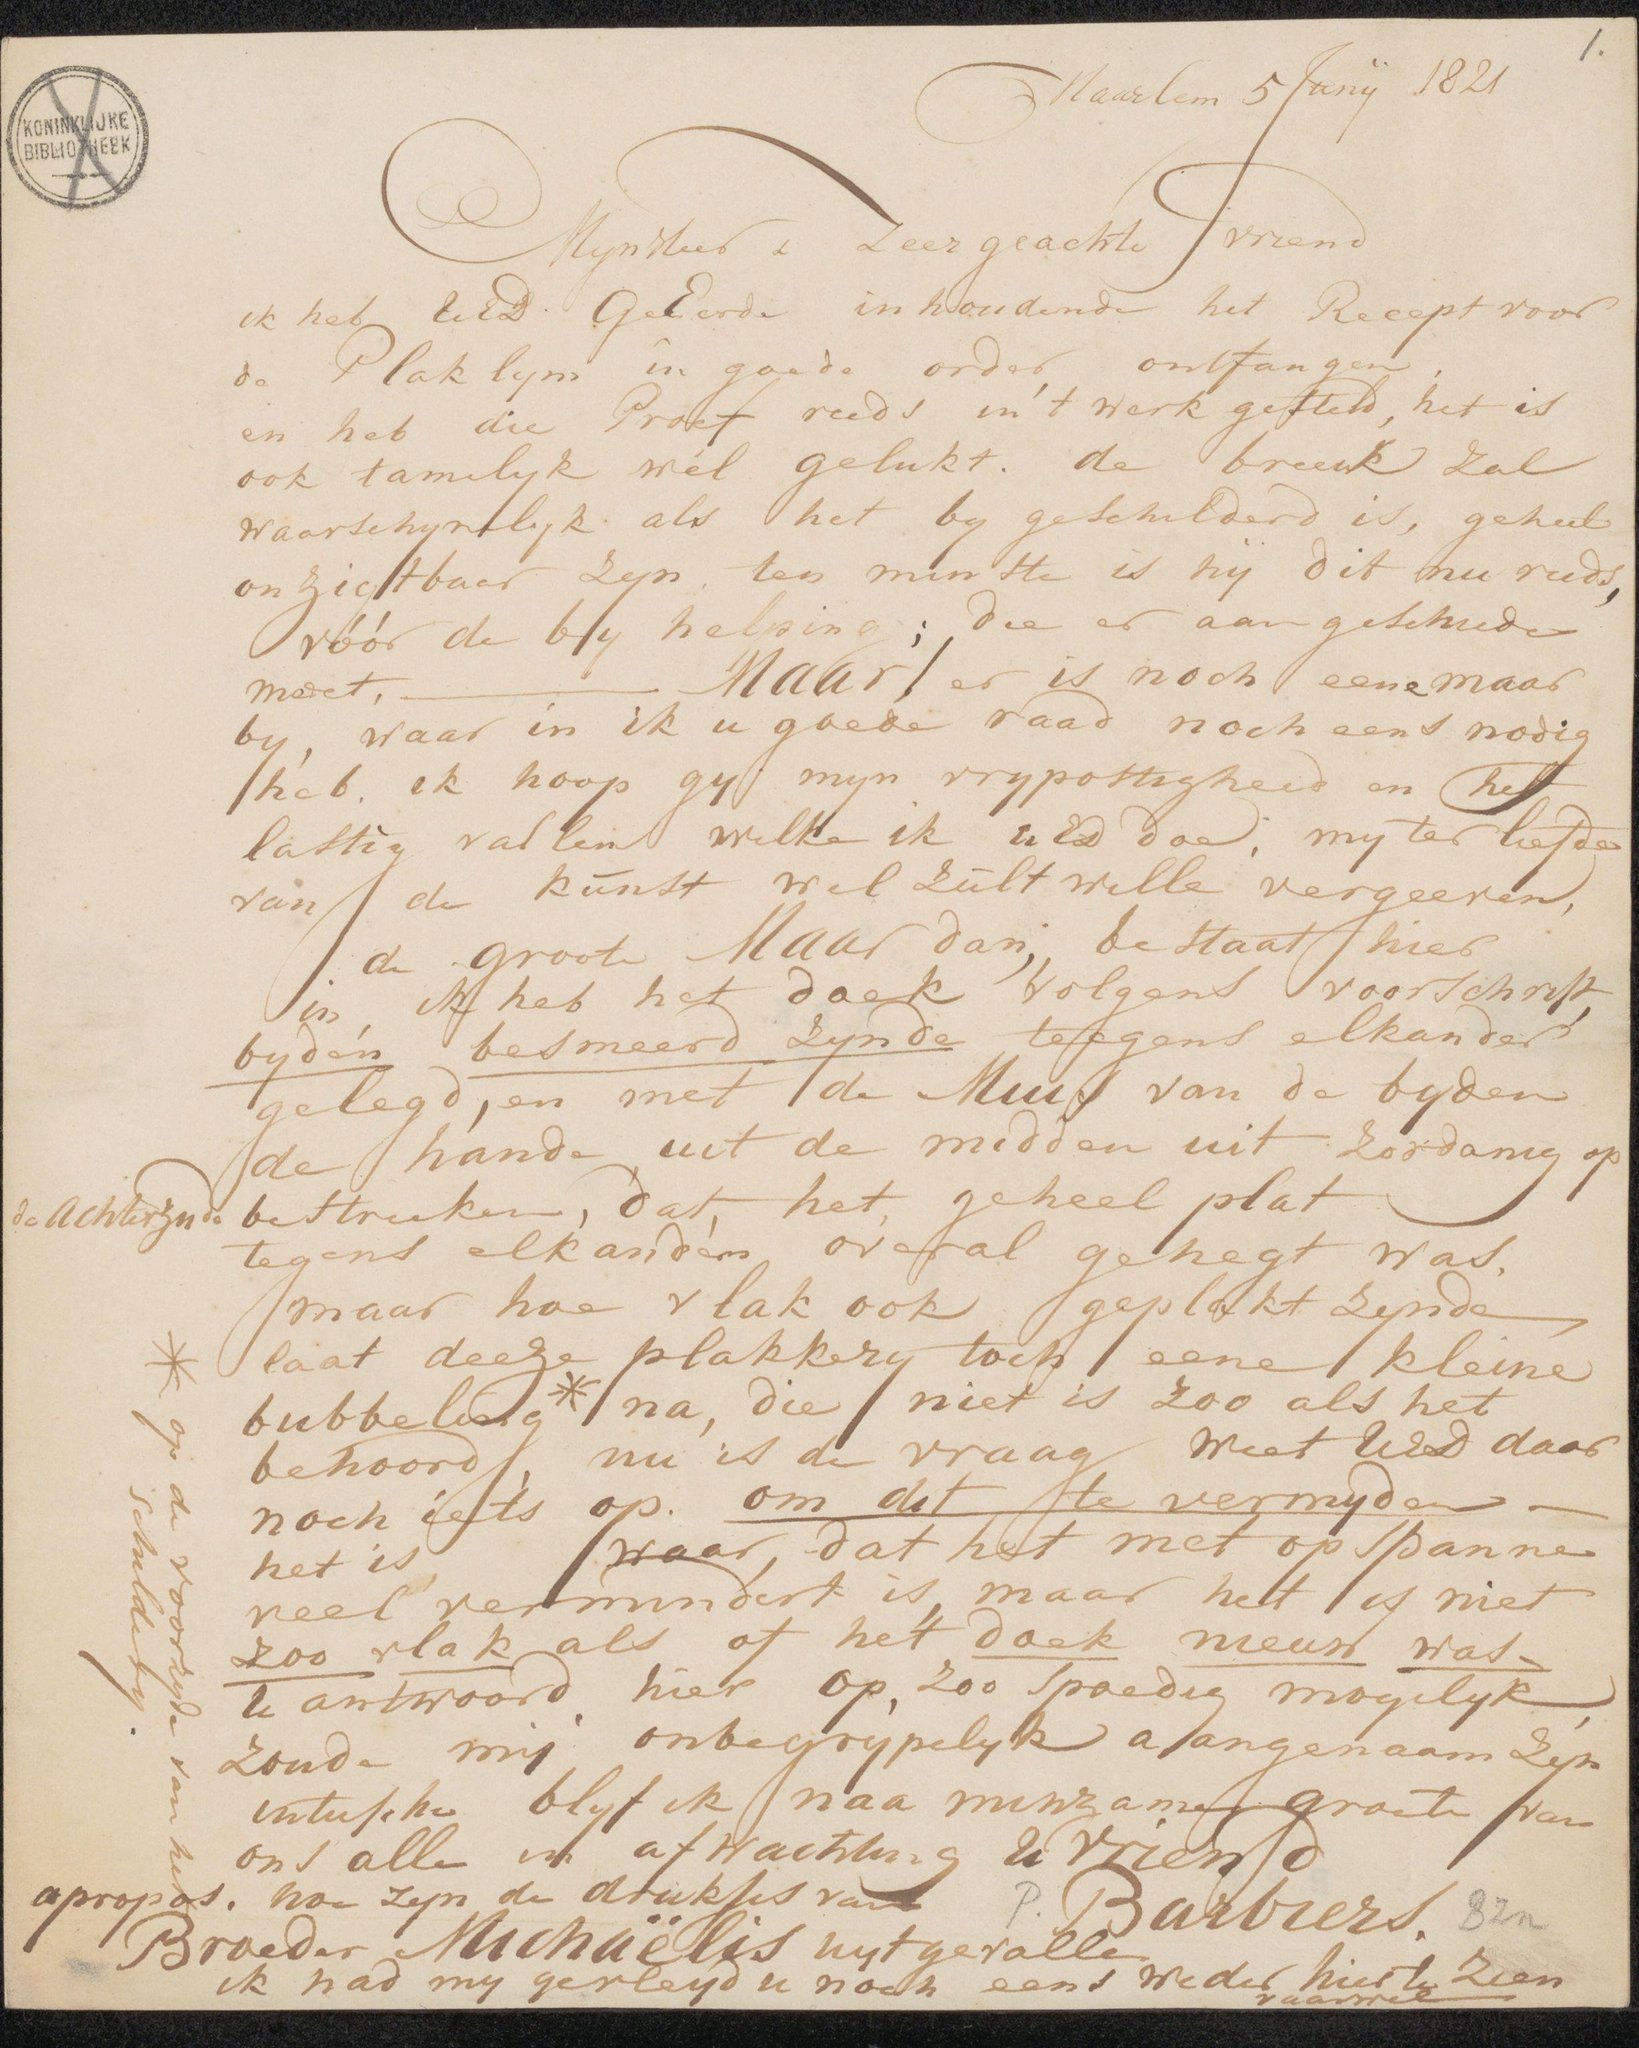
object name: letter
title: Brief aan Ernst Willem Jan Bagelaar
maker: pieter bartholomeusz. barbiers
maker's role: draughtsman, print maker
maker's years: 1772-1837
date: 1821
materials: ink, paper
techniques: pen, writing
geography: haarlem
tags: ernst willem jan bagelaar, painting (including book-illumination, miniature-painting)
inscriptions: collector's mark: ‘KONINKLIJKE/ BIBLIOTHEEK’, collector's mark: Lugt 2233